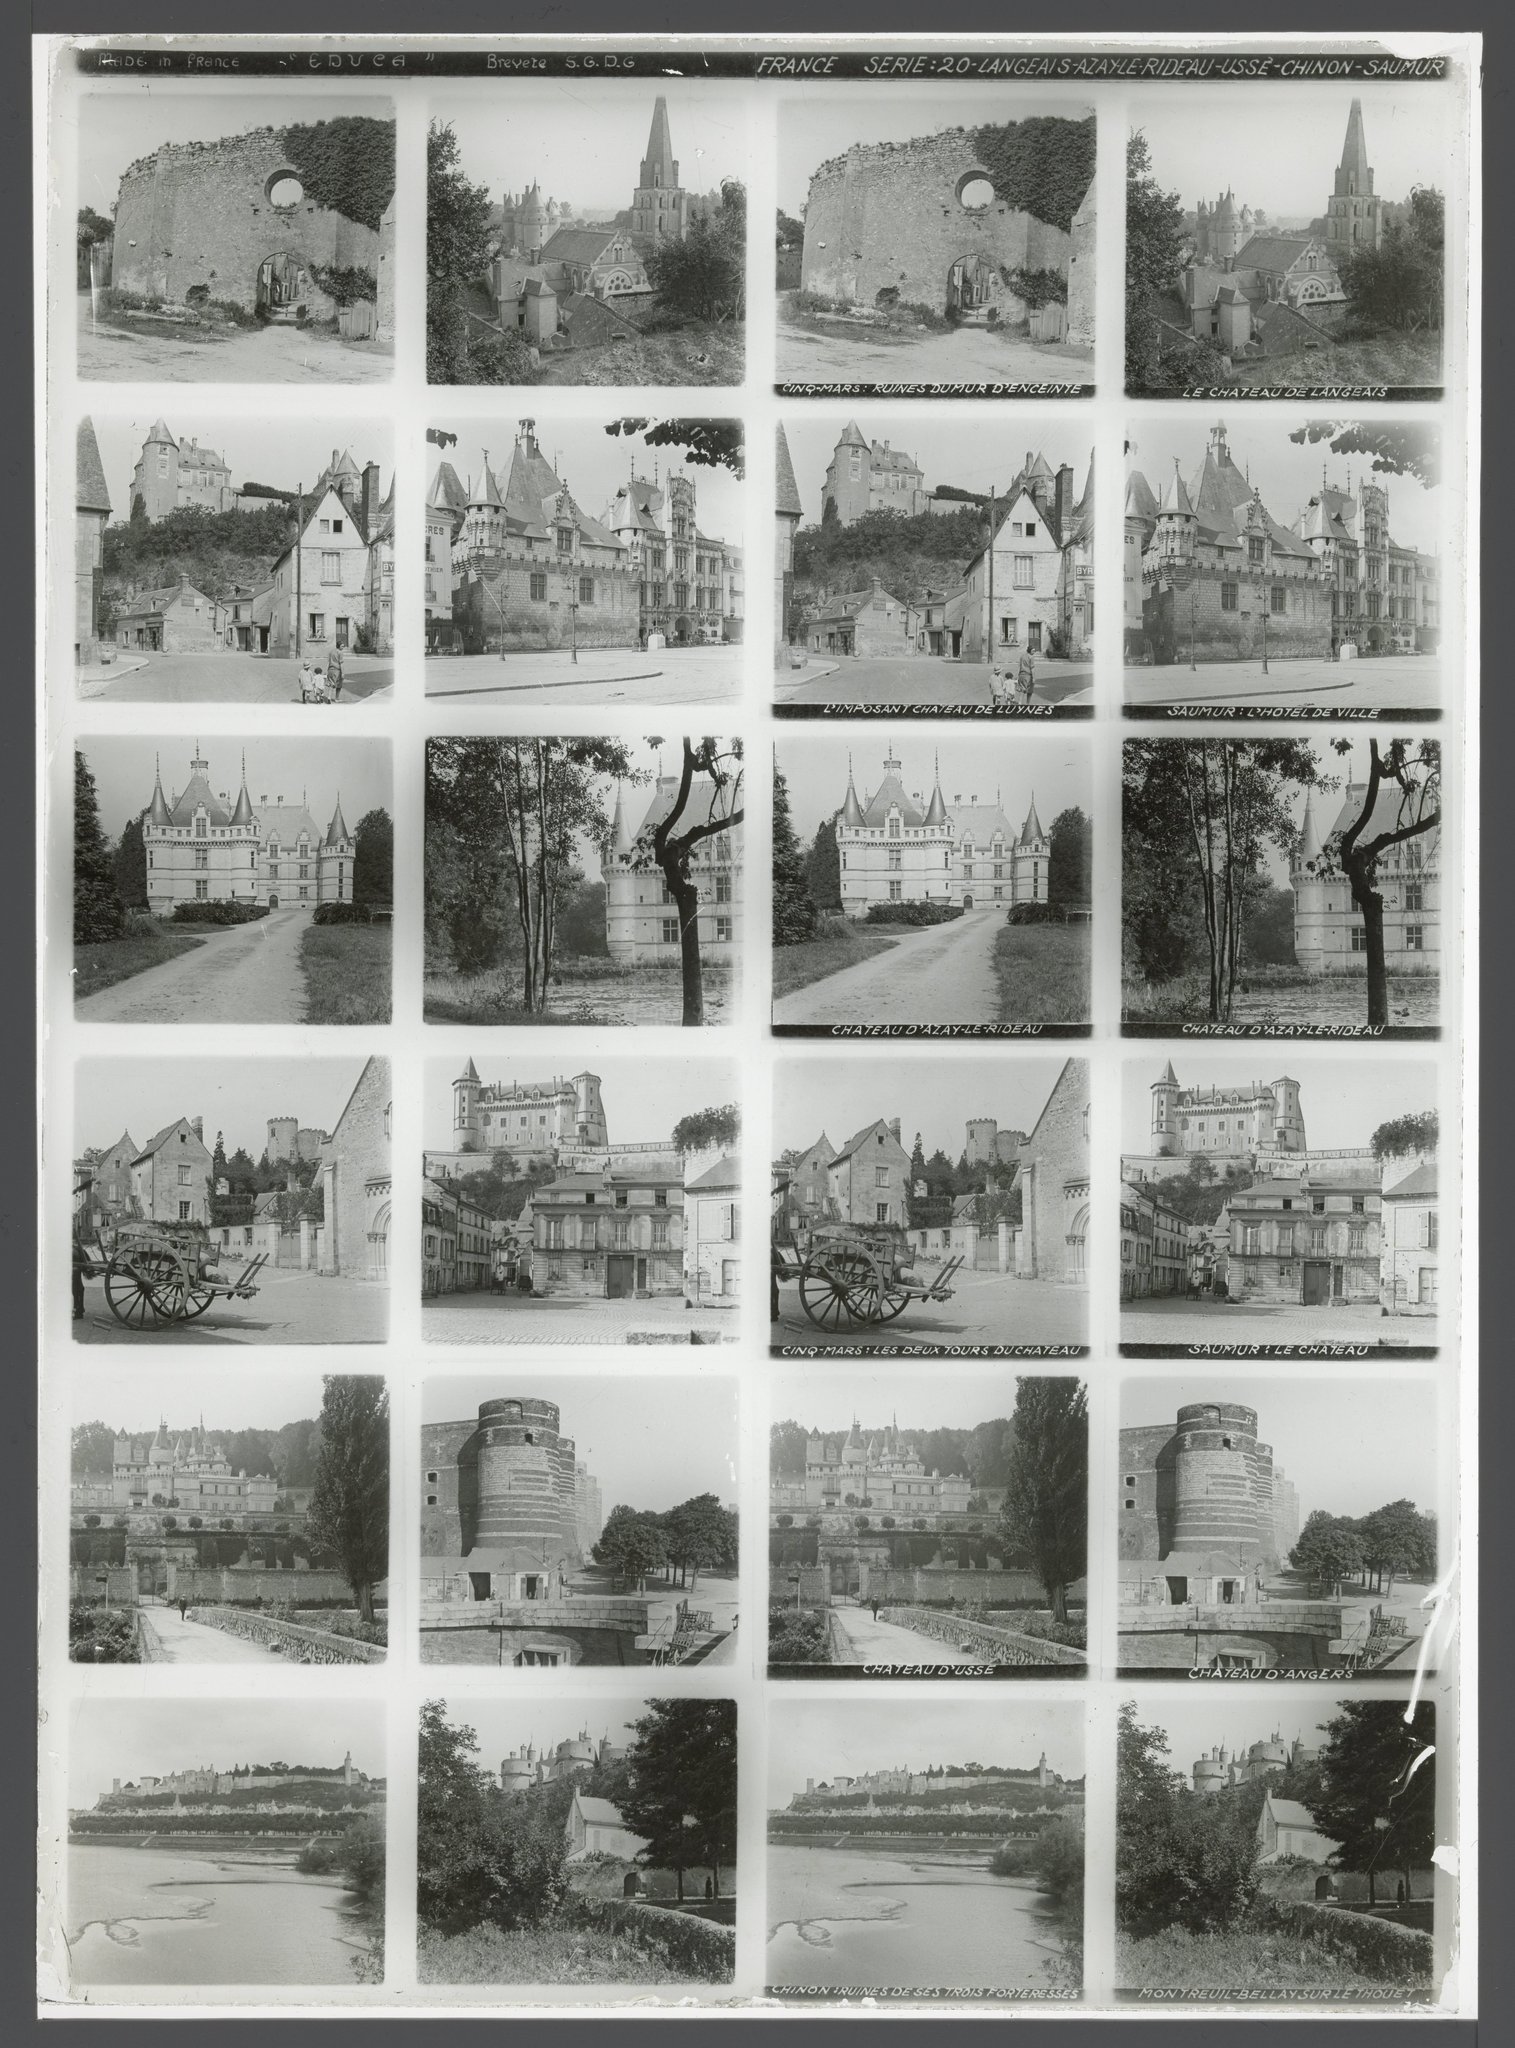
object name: stereoscopic photograph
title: France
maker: Anonymous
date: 1920-1925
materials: glass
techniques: gelatin silver transparency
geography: paris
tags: castle, townhall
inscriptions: inscription: ‘Made in France (...) Brevete S.G.D.G. (...)’